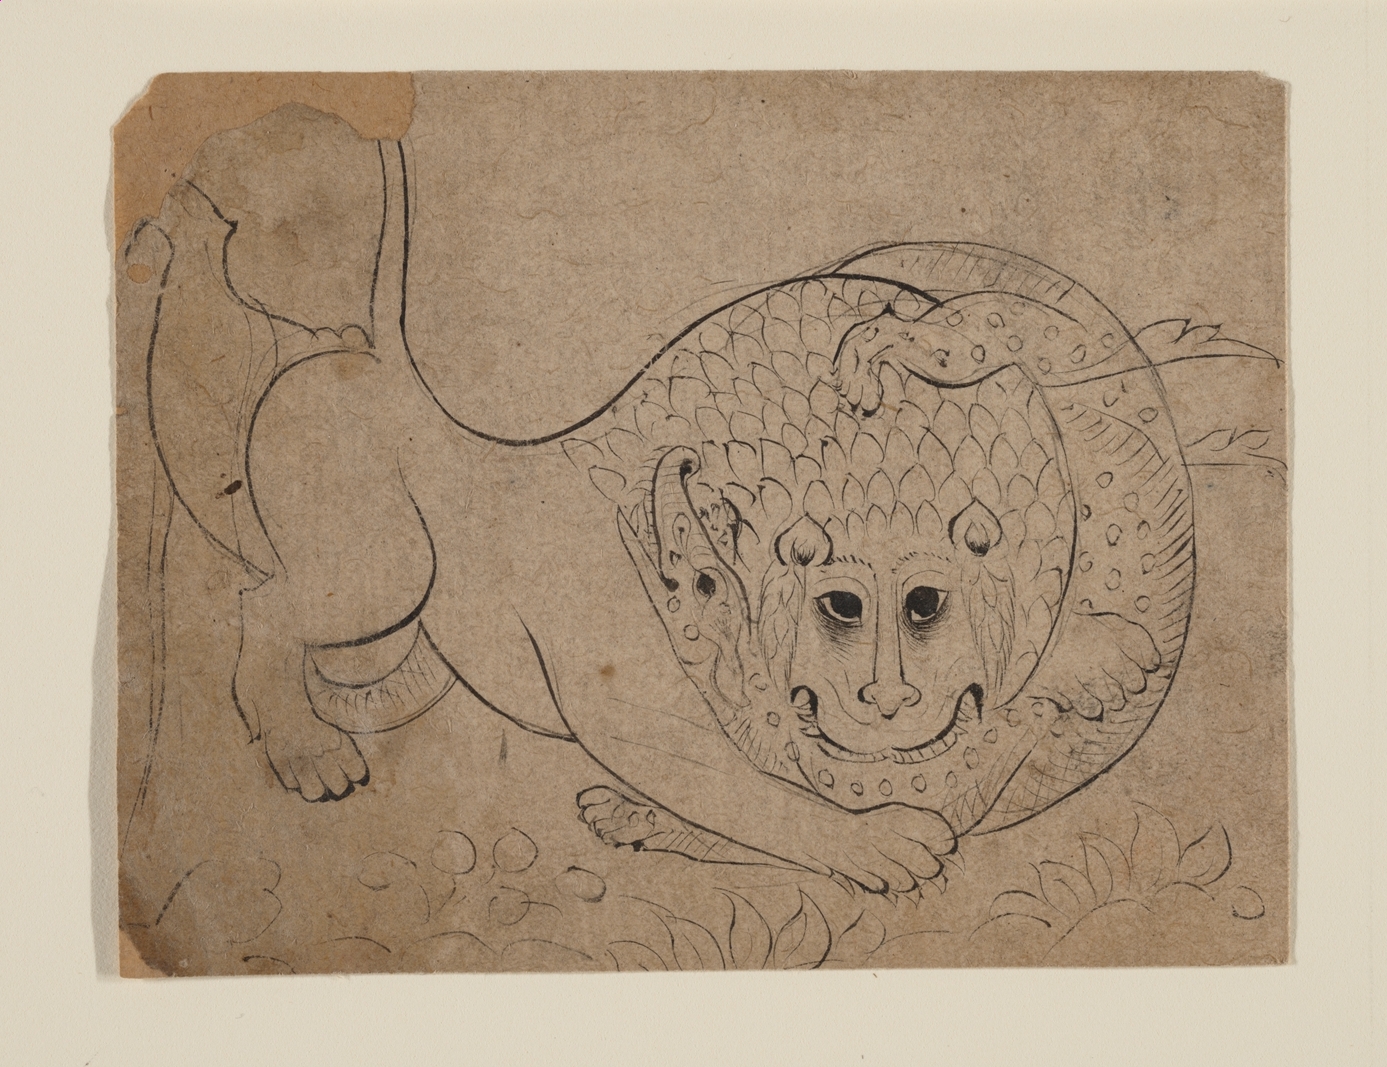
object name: drawing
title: A Lion Fighting a Crocodile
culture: indian or rajasthan or bundi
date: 1801-1833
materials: ink, paper, watercolor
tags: crocodiles,lions